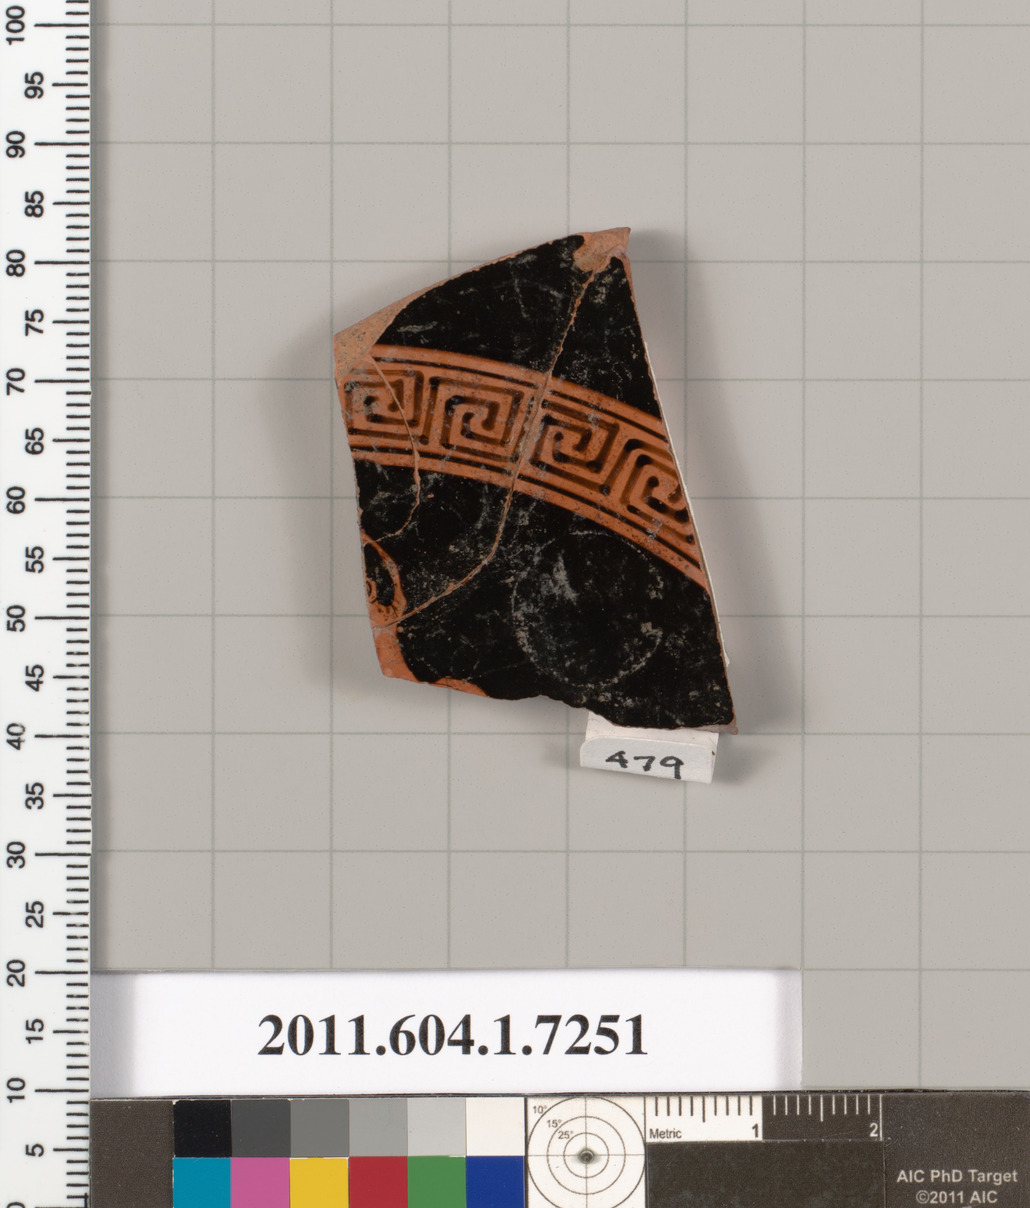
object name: kylix fragment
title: Terracotta fragment of a kylix (drinking cup)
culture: greek, attic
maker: makron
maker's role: artist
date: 500-480 BCE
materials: terracotta